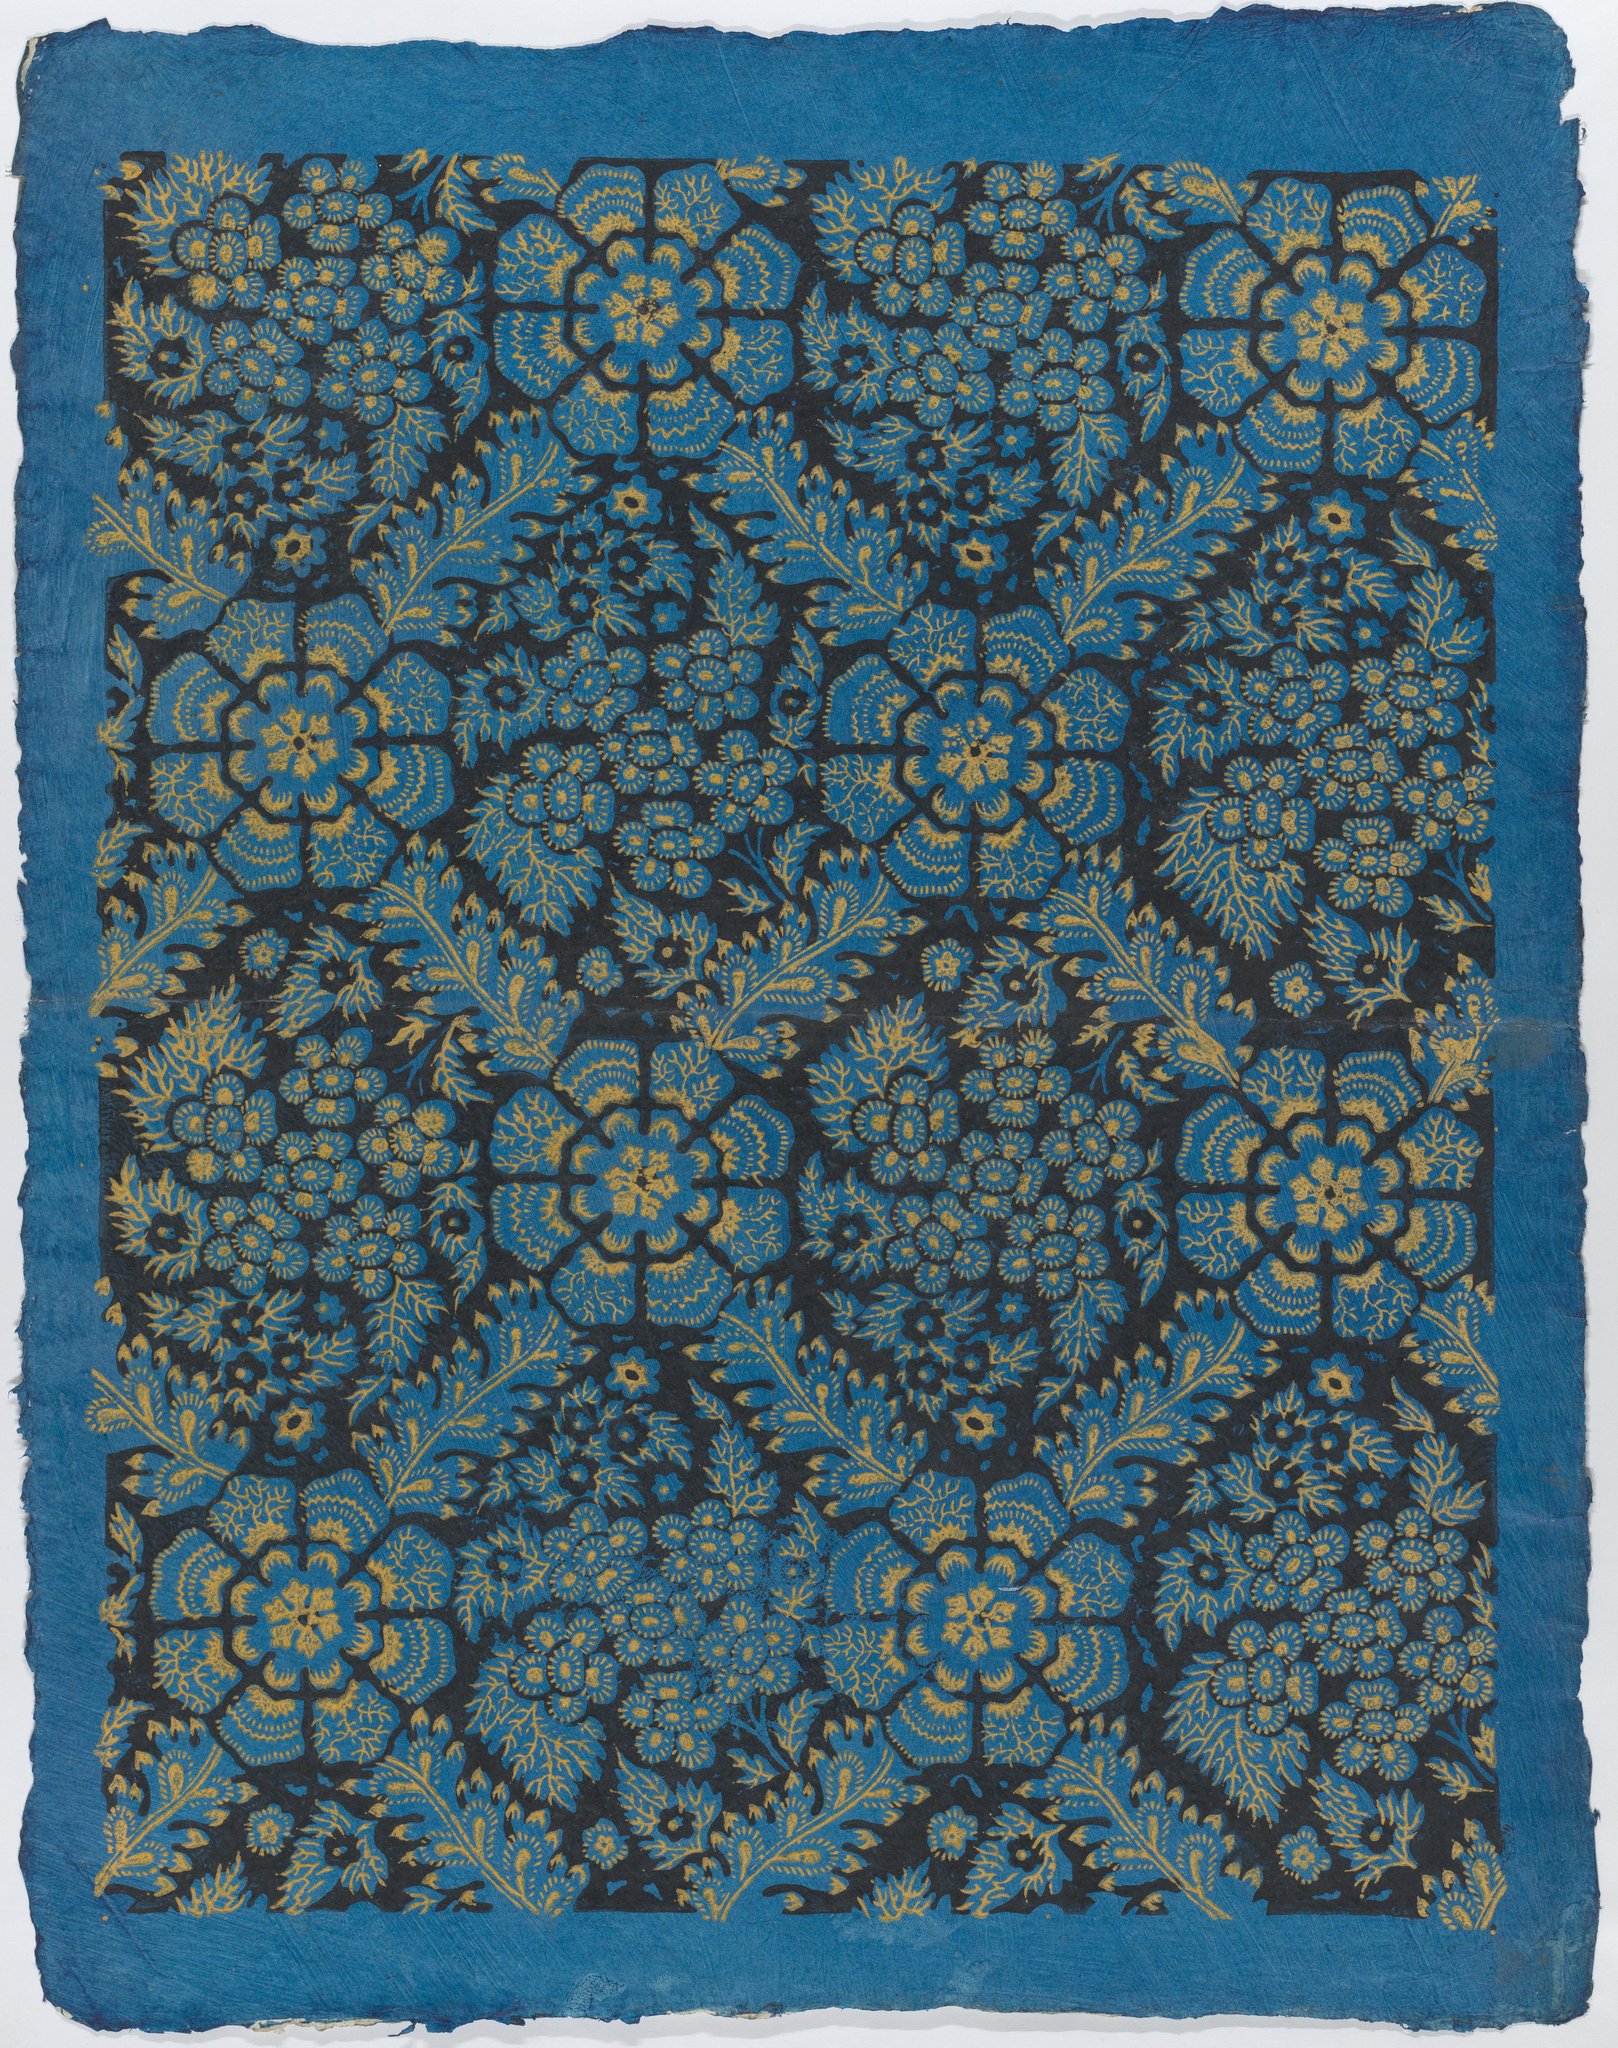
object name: print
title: Sheet with overall black and gold floral pattern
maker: Anonymous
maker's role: artist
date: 1767-1866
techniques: relief print